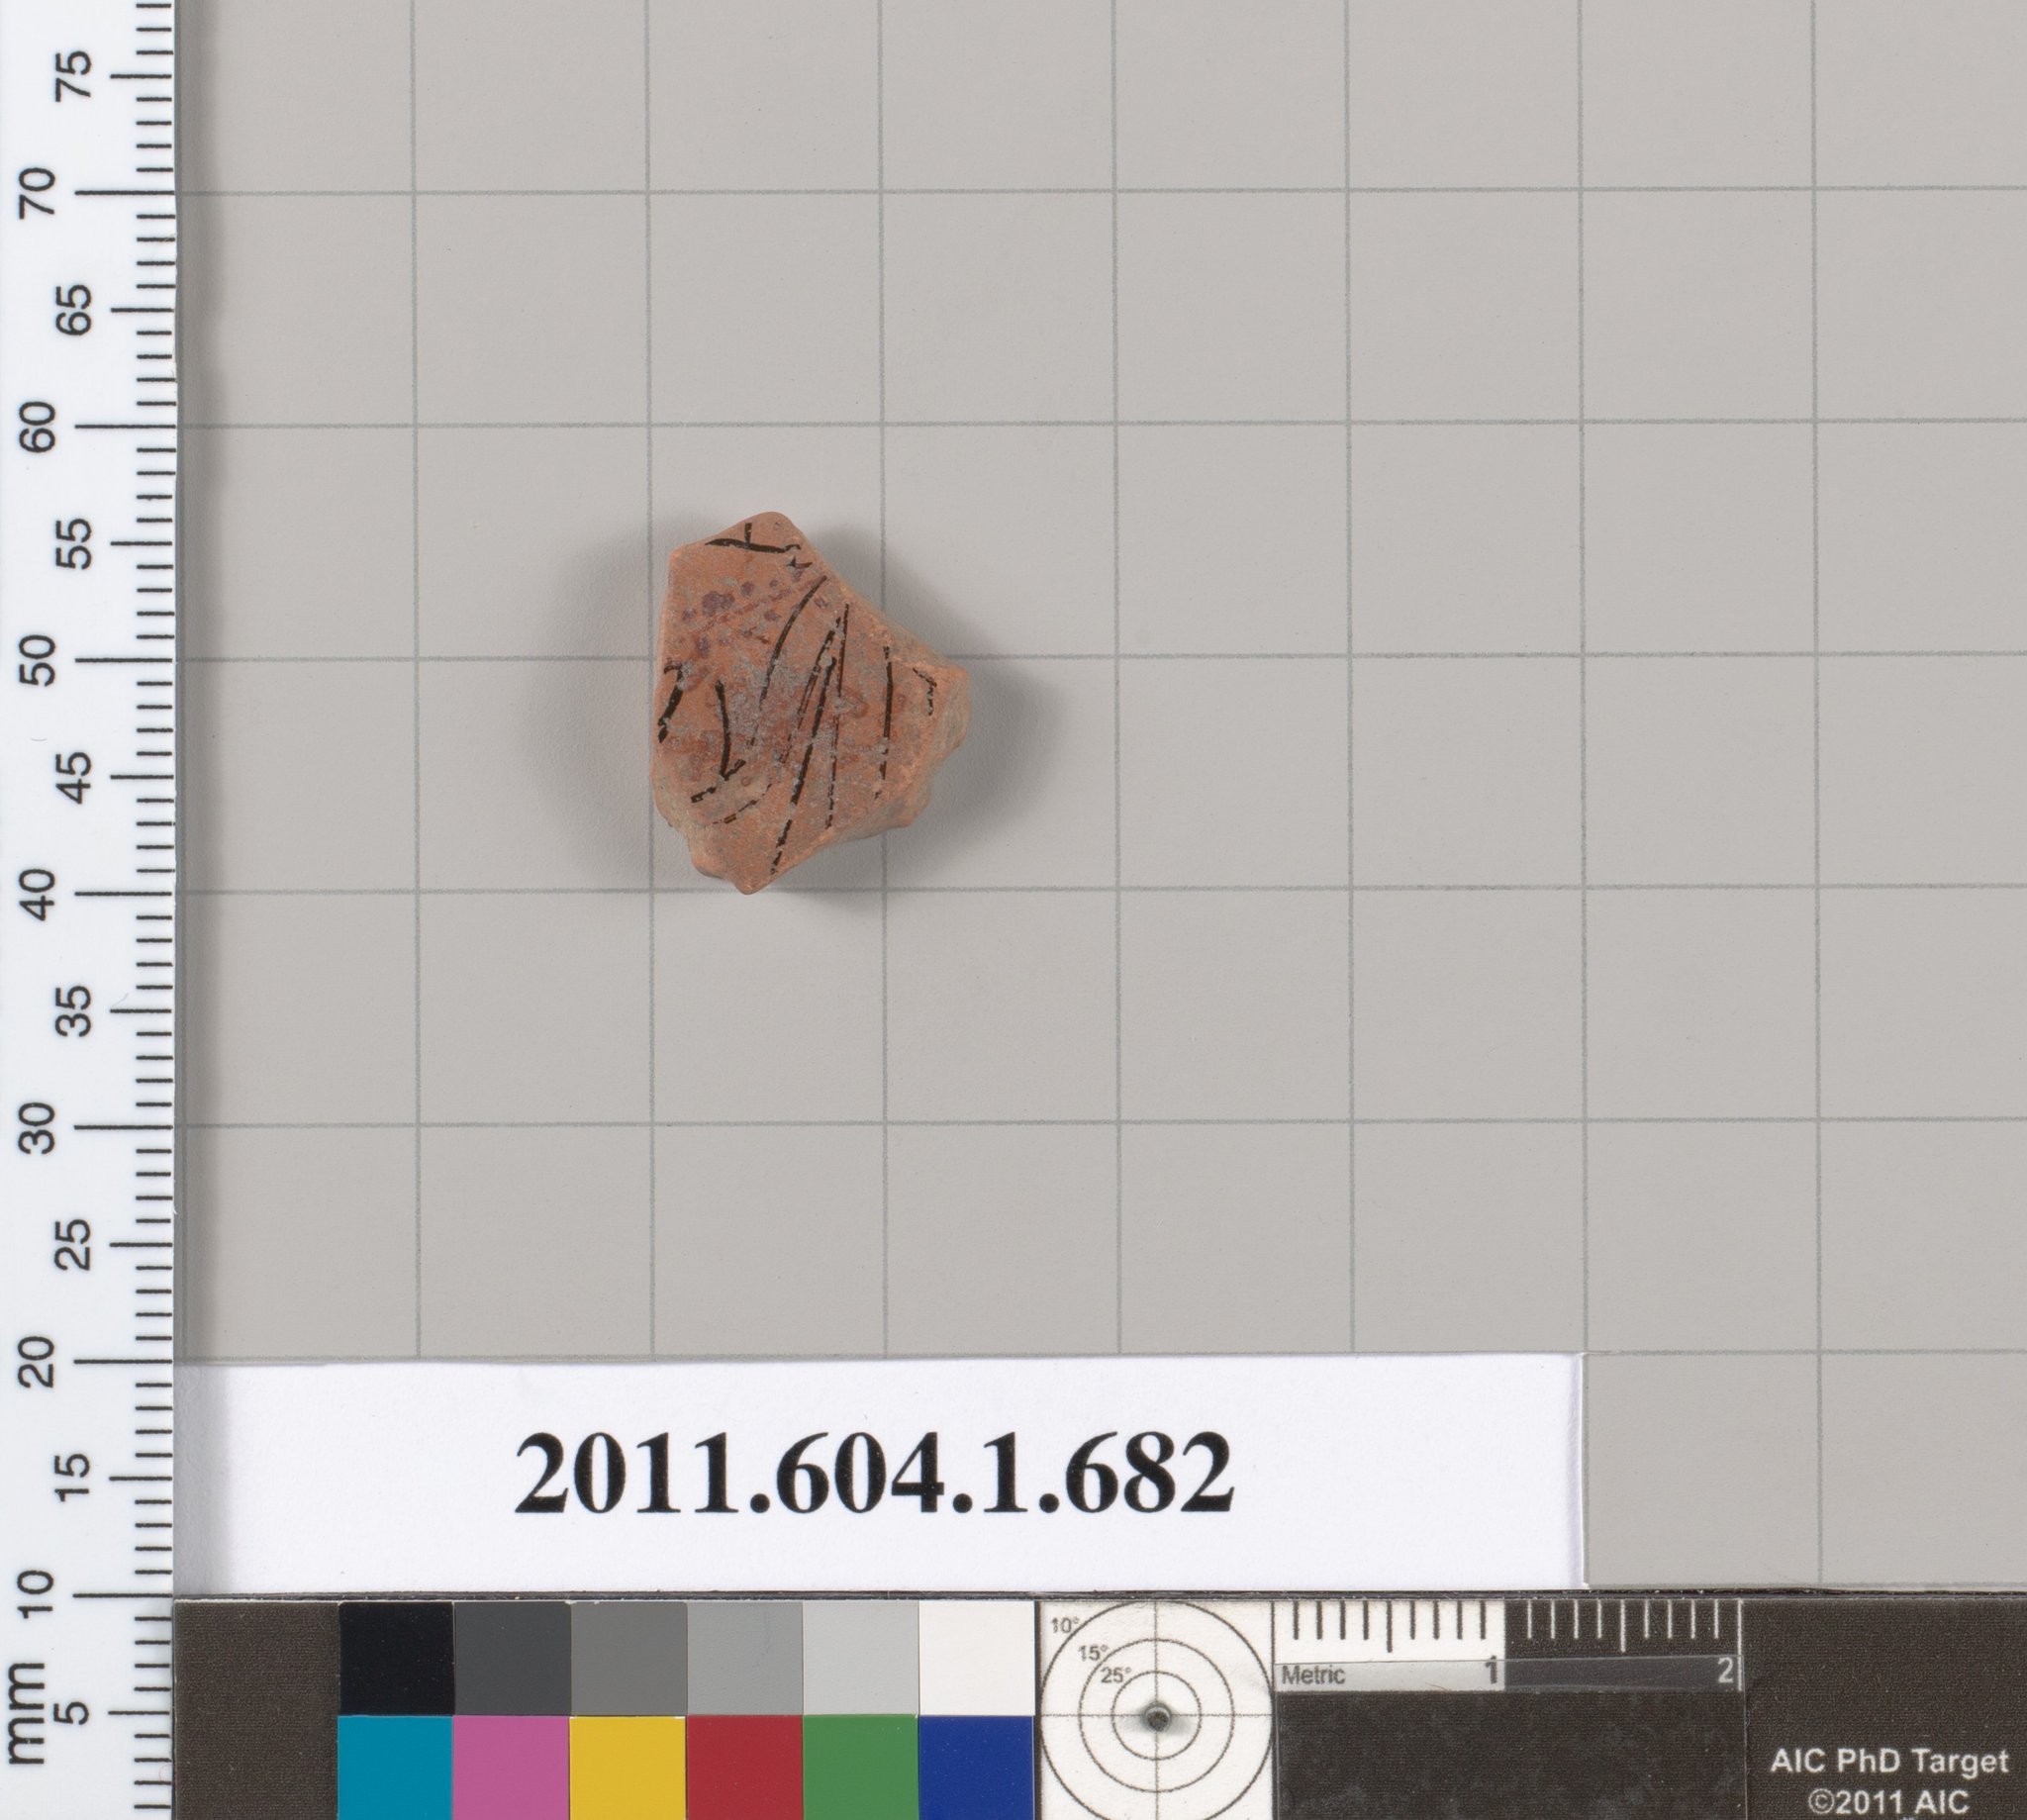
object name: kylix fragment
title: Terracotta fragment of a kylix (drinking cup)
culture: greek, attic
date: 475-451 BCE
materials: terracotta